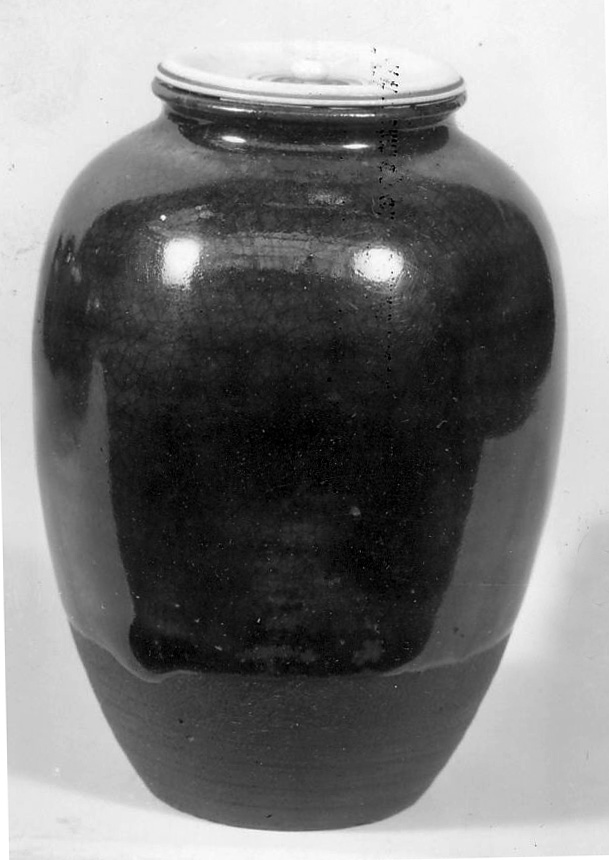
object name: tea jar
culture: japanese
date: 1701-1800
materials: clay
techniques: overglaze, underglaze